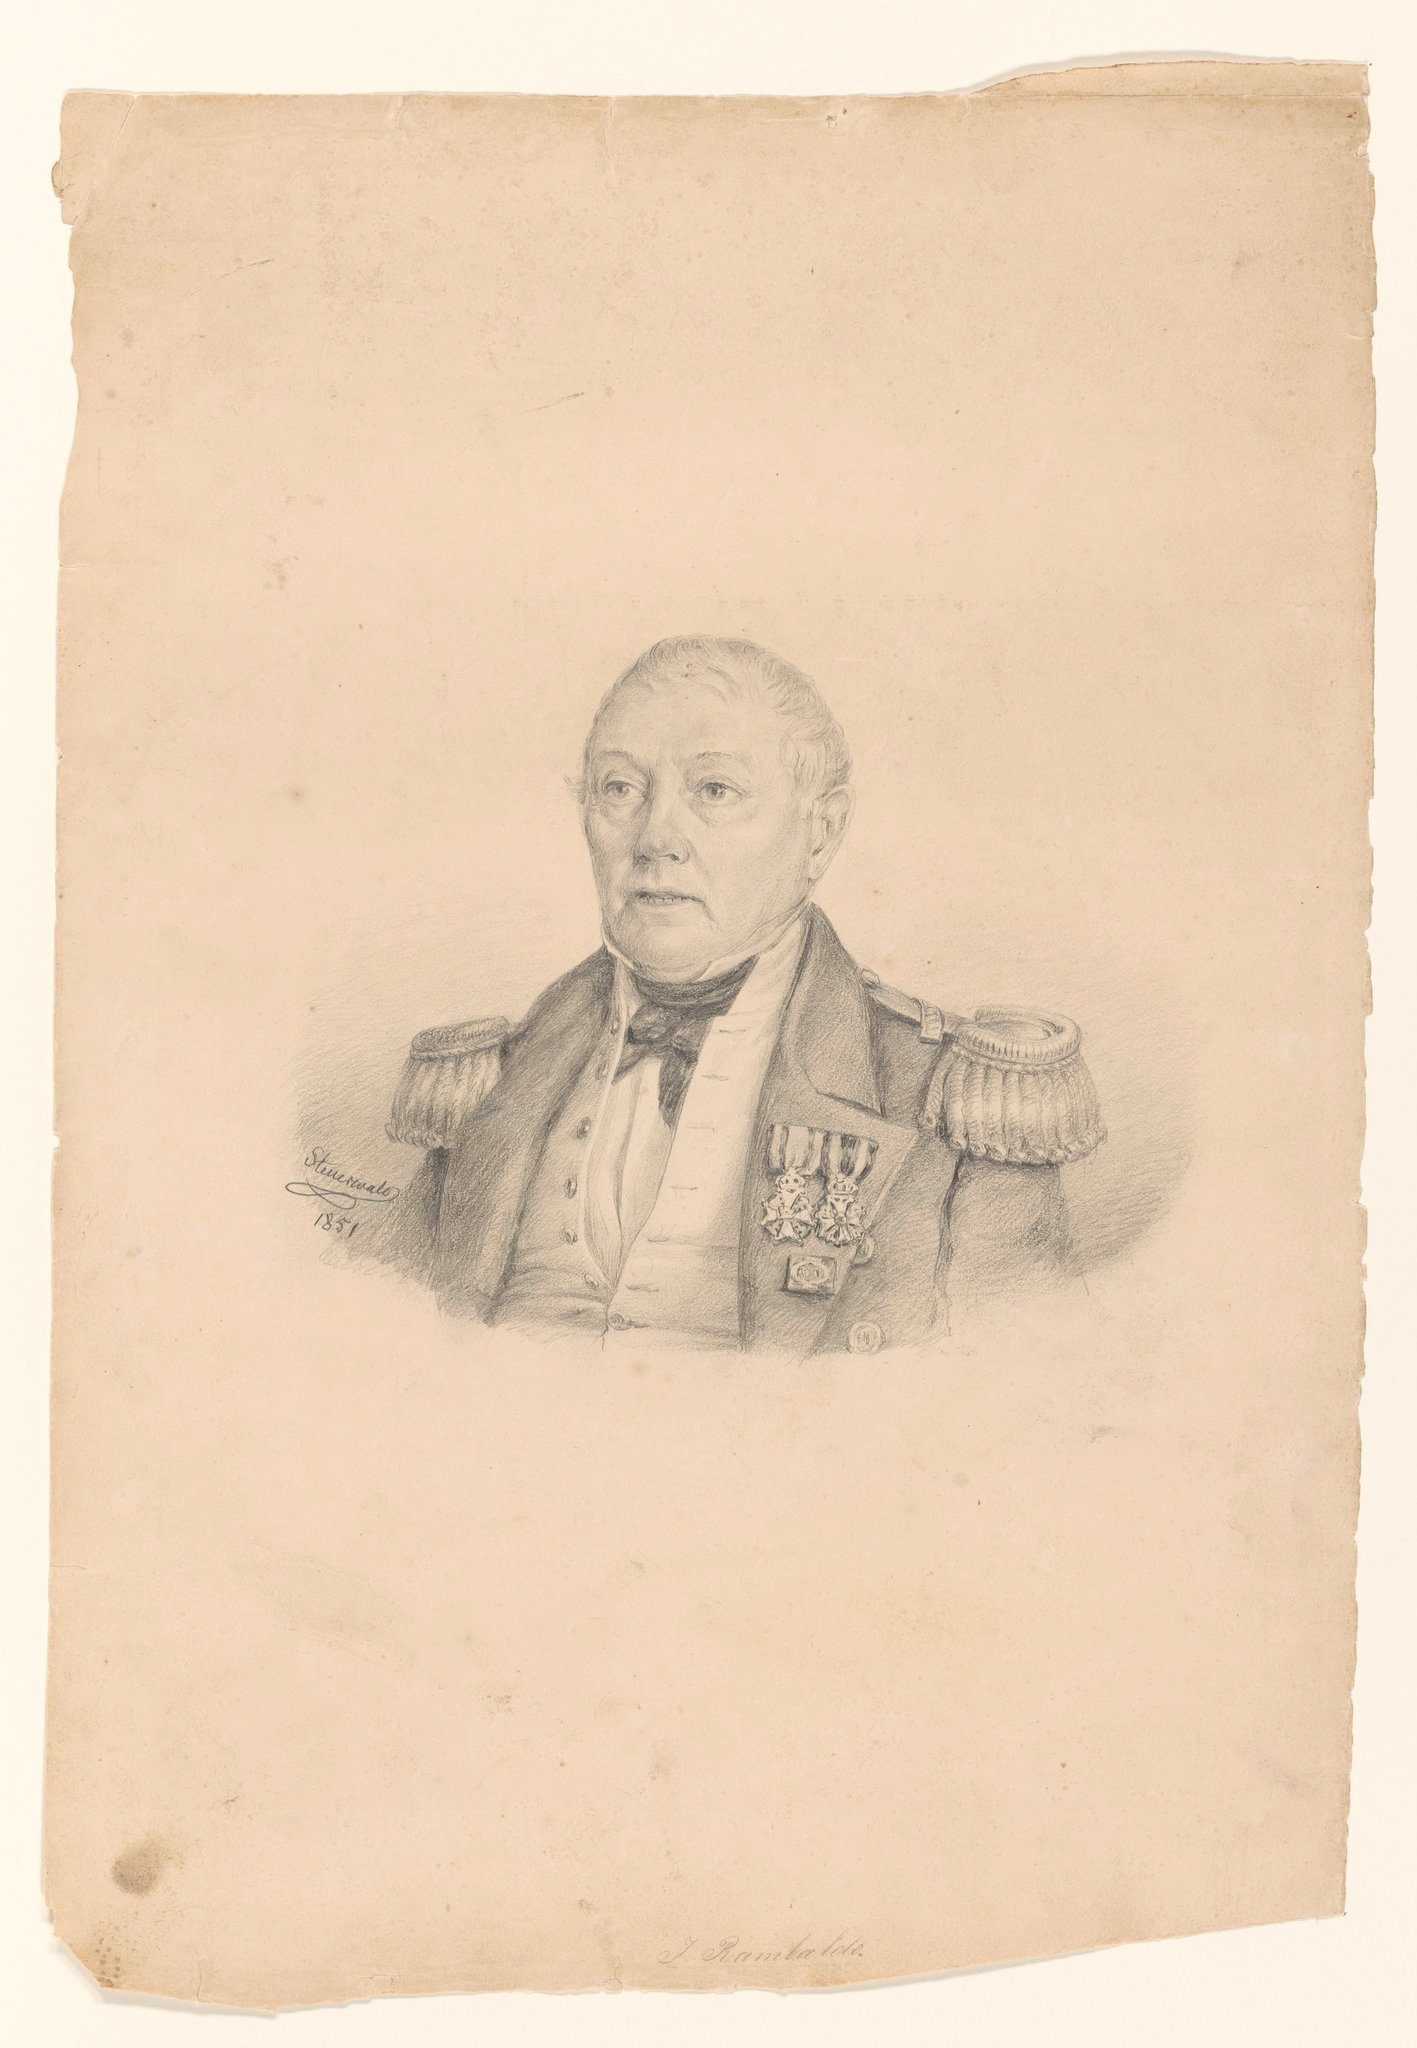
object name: drawing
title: Portret van J. Rambaldo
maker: christian heinrich gottlieb steuerwald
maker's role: draughtsman, print maker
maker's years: 1802-1874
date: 1851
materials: paper, pencil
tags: amsterdam, historical persons